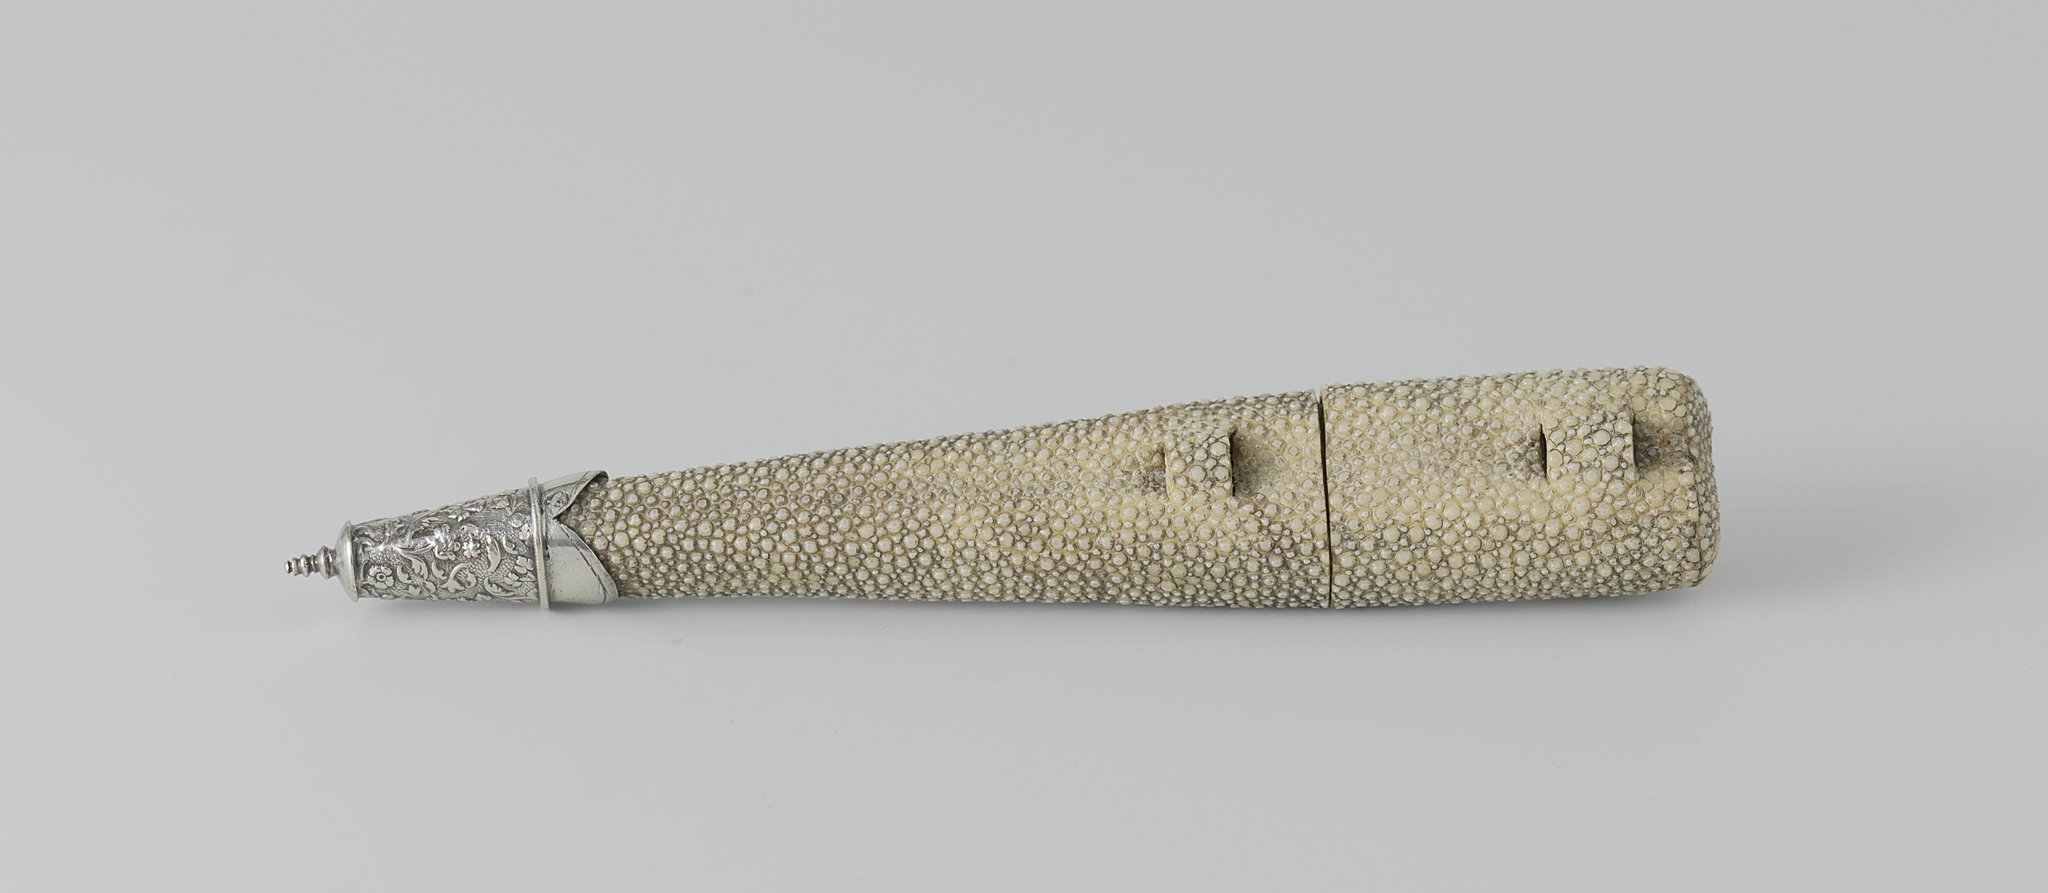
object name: étui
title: Case for a travelling cutlery set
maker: Anonymous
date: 1675-1700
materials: skin, silver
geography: netherlands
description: Etui van robbenvel met fraai zilveren punt met gedreven bloemperk.